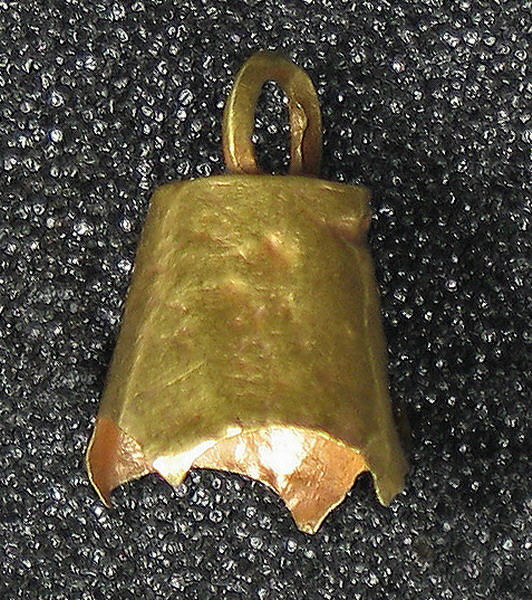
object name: pendant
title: Pendant of Bell Form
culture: indonesian, central java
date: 701-1200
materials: gold